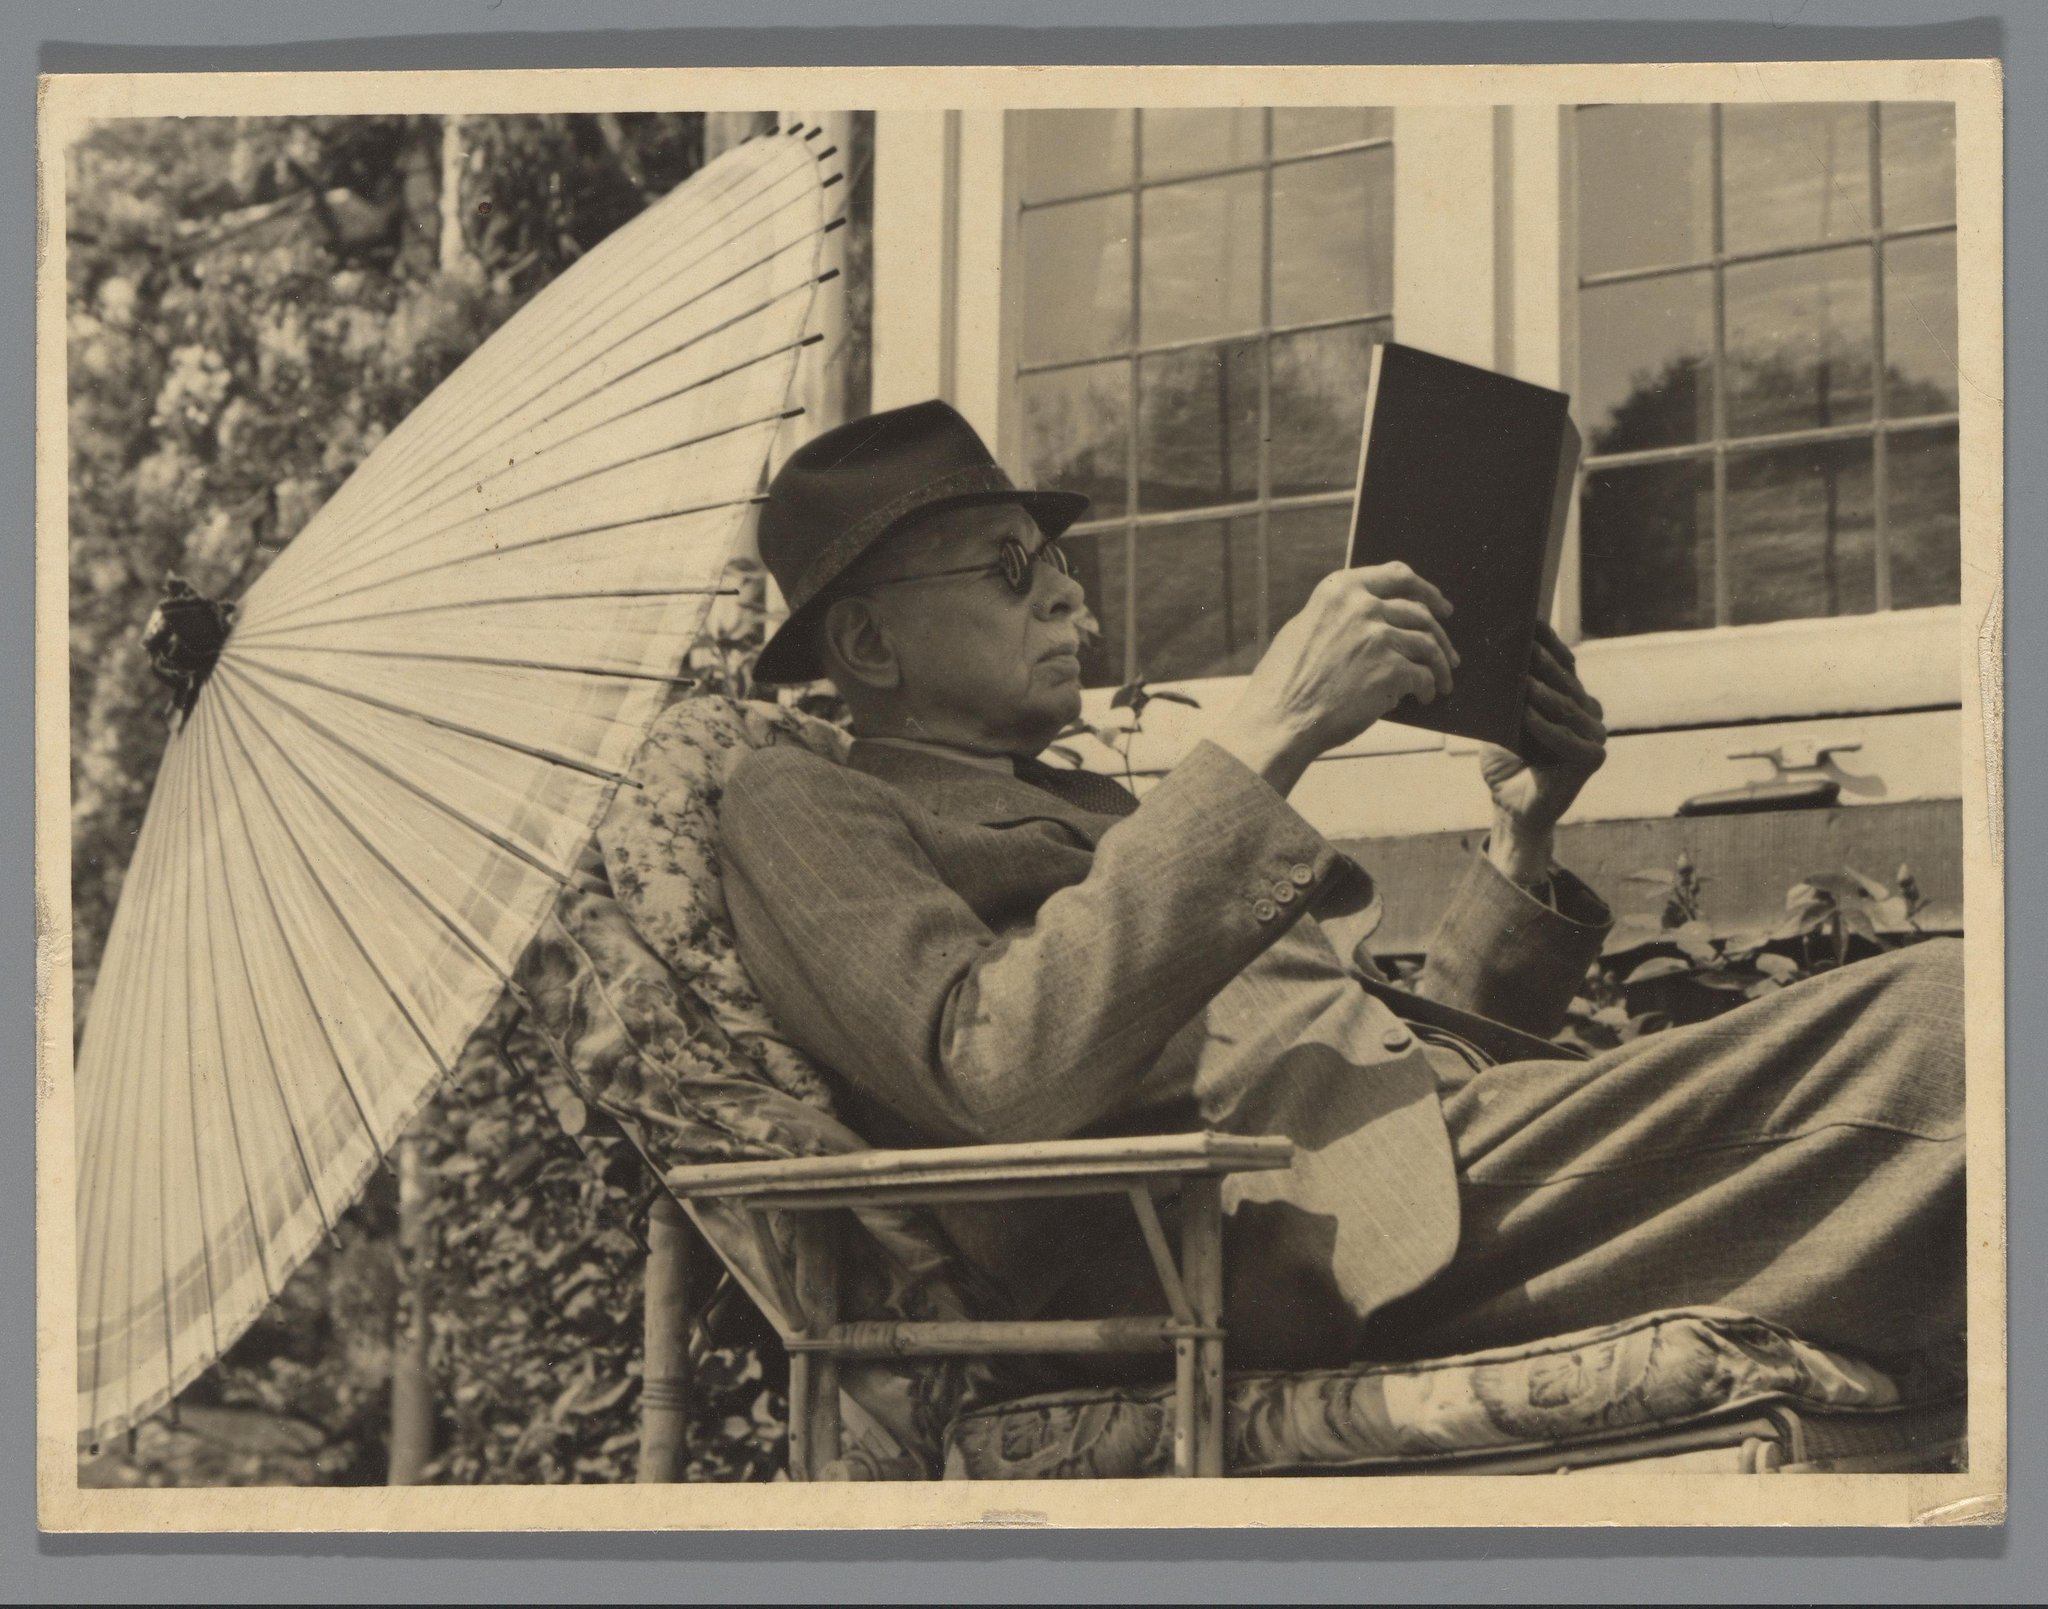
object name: photograph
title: Karel Frederik van den Berg met hoed en zonnebril lezend onder een parasol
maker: Anonymous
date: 1935-1945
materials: photographic support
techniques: photography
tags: batavia, karel frederik van den berg